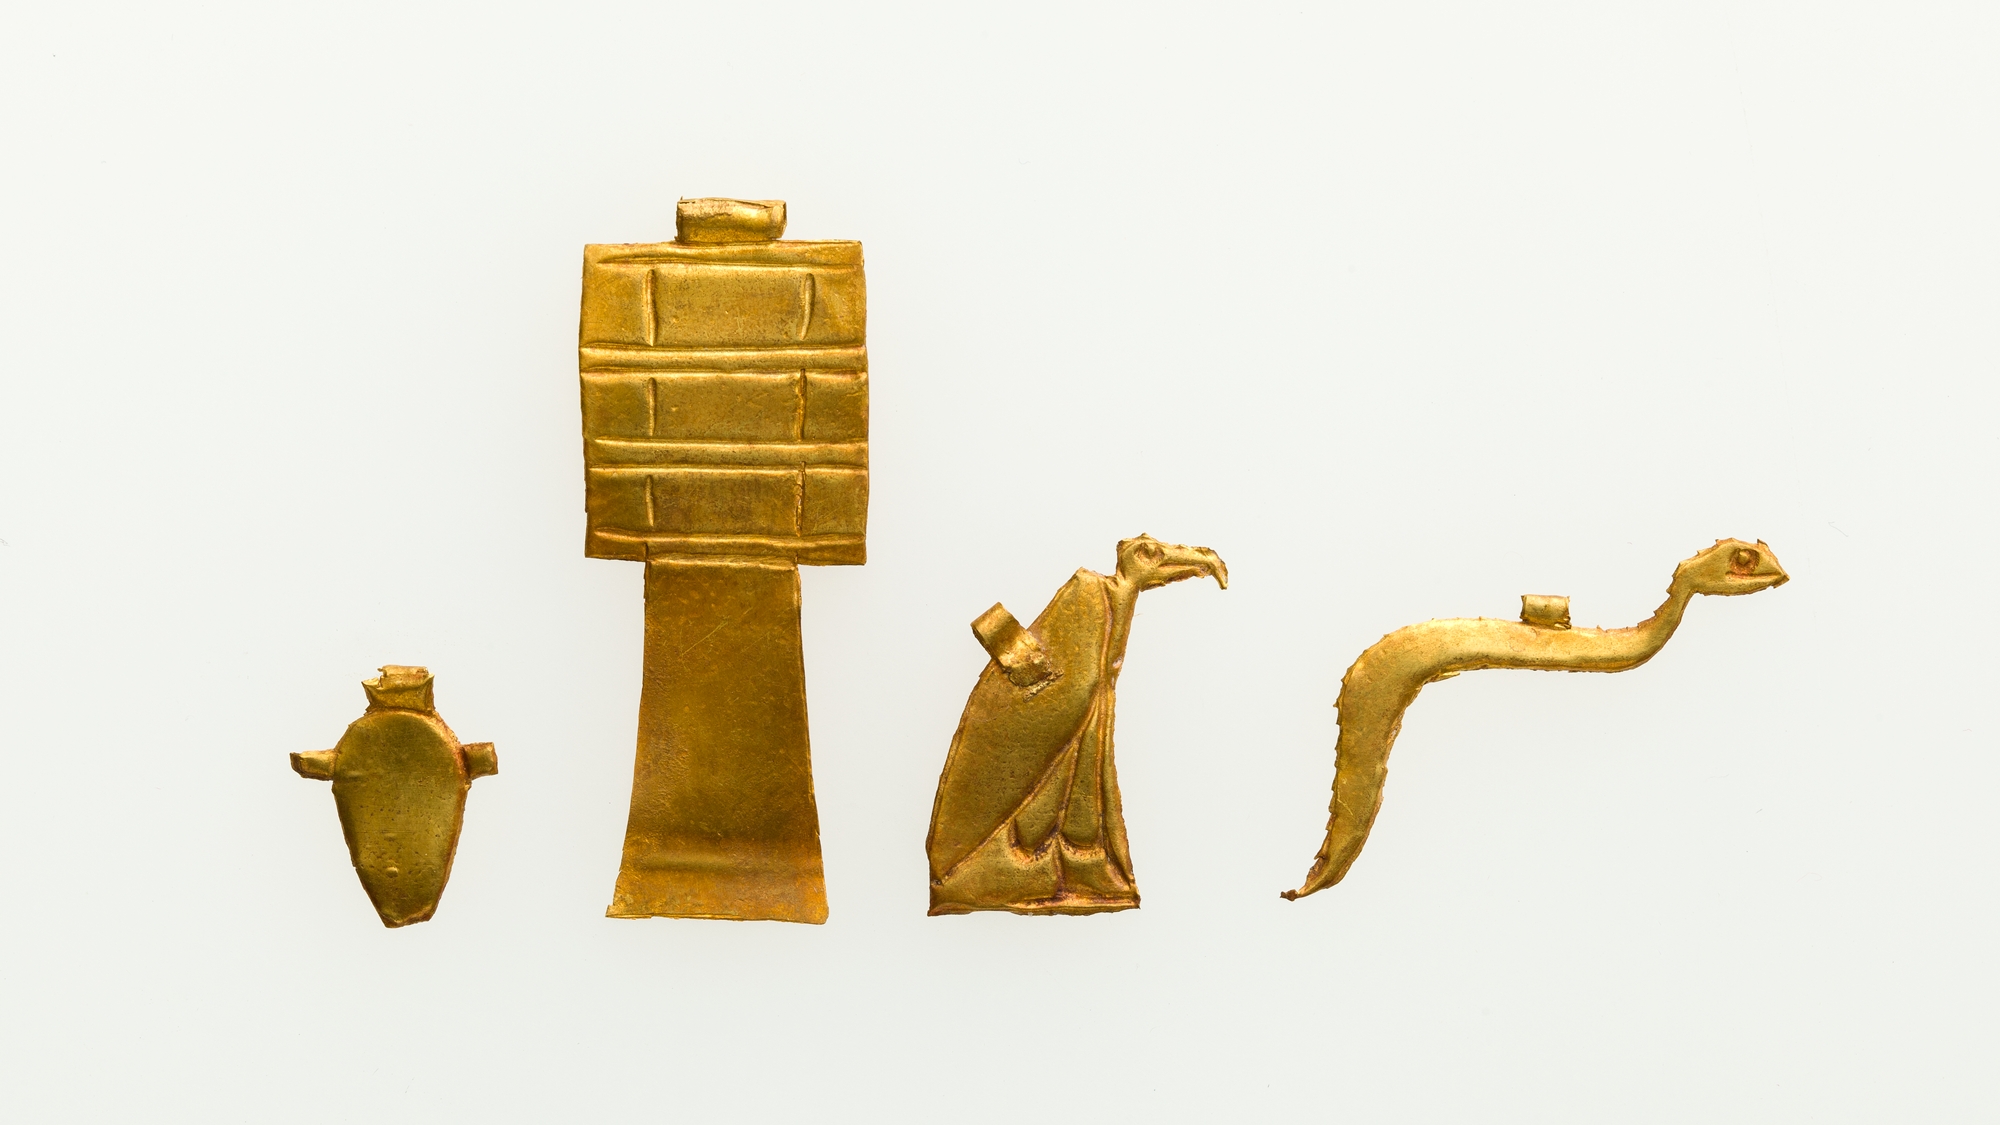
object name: amulet, djedmutesankh, ib heart, djed pillar, cobra, vulture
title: Group of Four Amulets: Cobra, Vulture, Djed Pillar, and Heart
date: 1000-945 BCE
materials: gold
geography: egypt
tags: birds,hearts,snakes